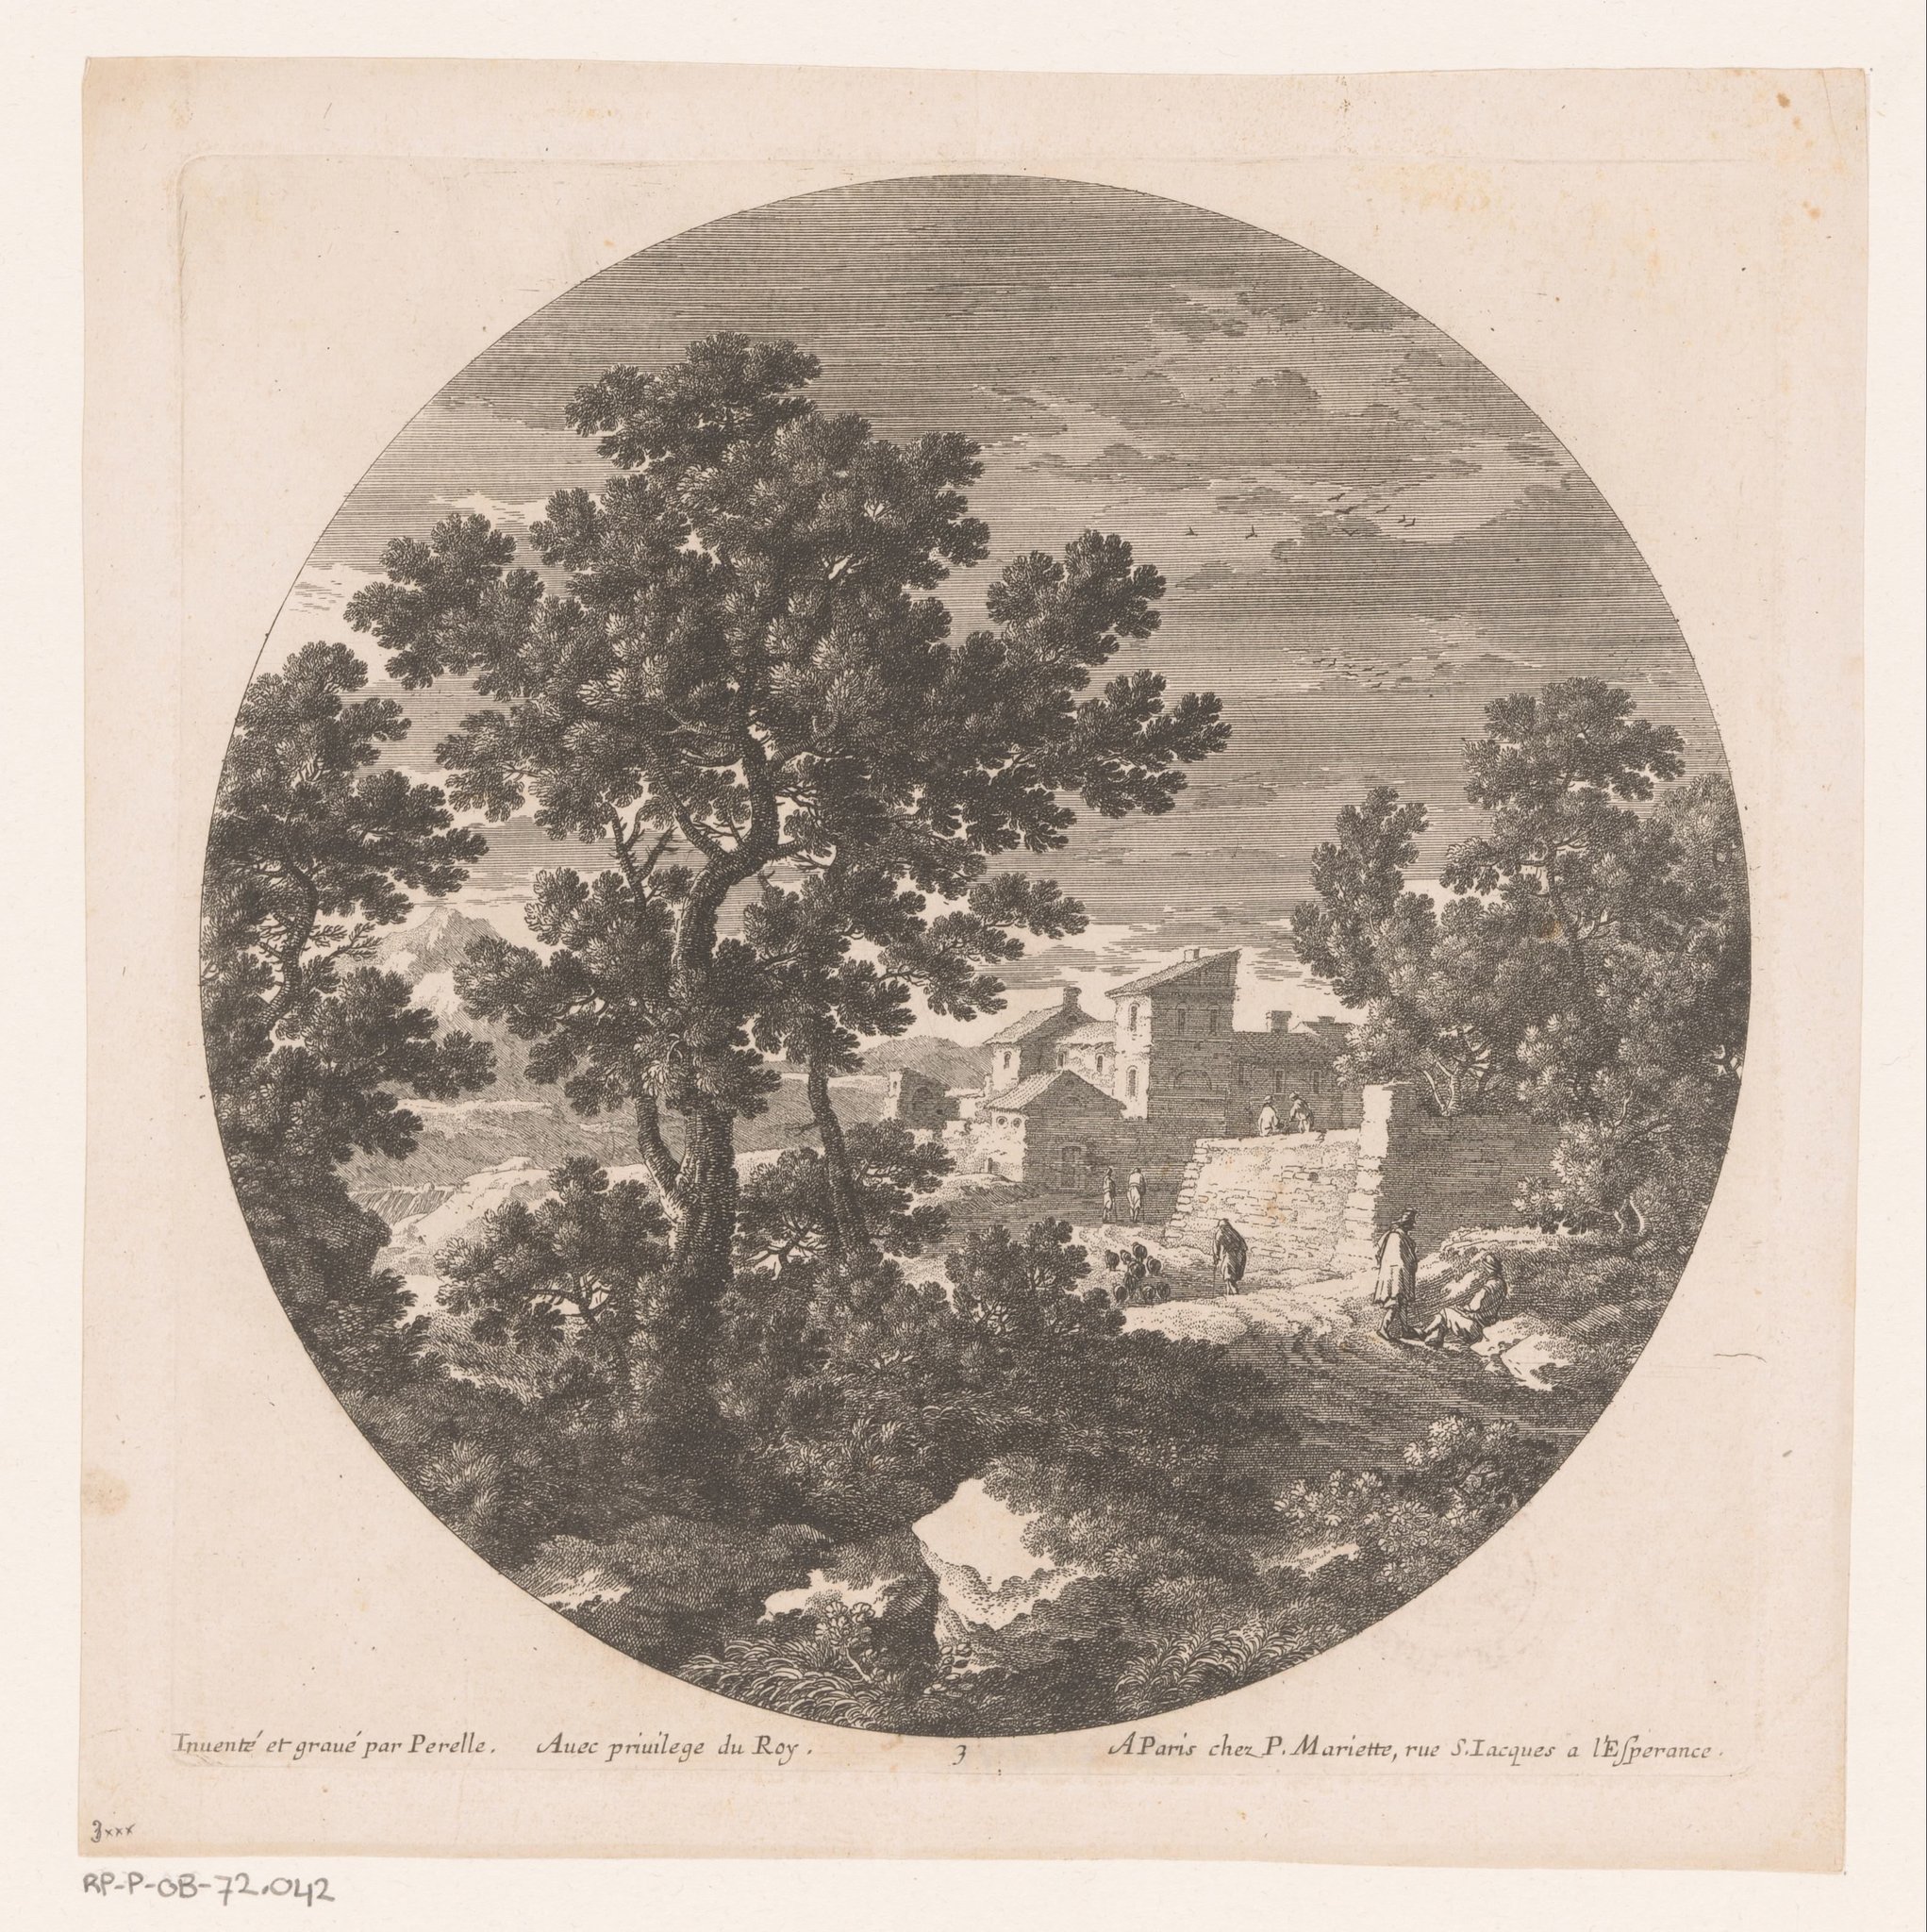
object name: print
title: Figuren aan de rand van een dorp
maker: pierre mariette (i)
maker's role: print maker, publisher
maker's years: 1596-1657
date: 1613-1657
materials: paper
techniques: engraving, etching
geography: paris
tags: outskirts of village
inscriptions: collector's mark: Lugt 240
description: Prenten met het signatuur 'Perelle' kunnen zowel door vader Gabriel als door zonen Nicolas en Adam gemaakt zijn.